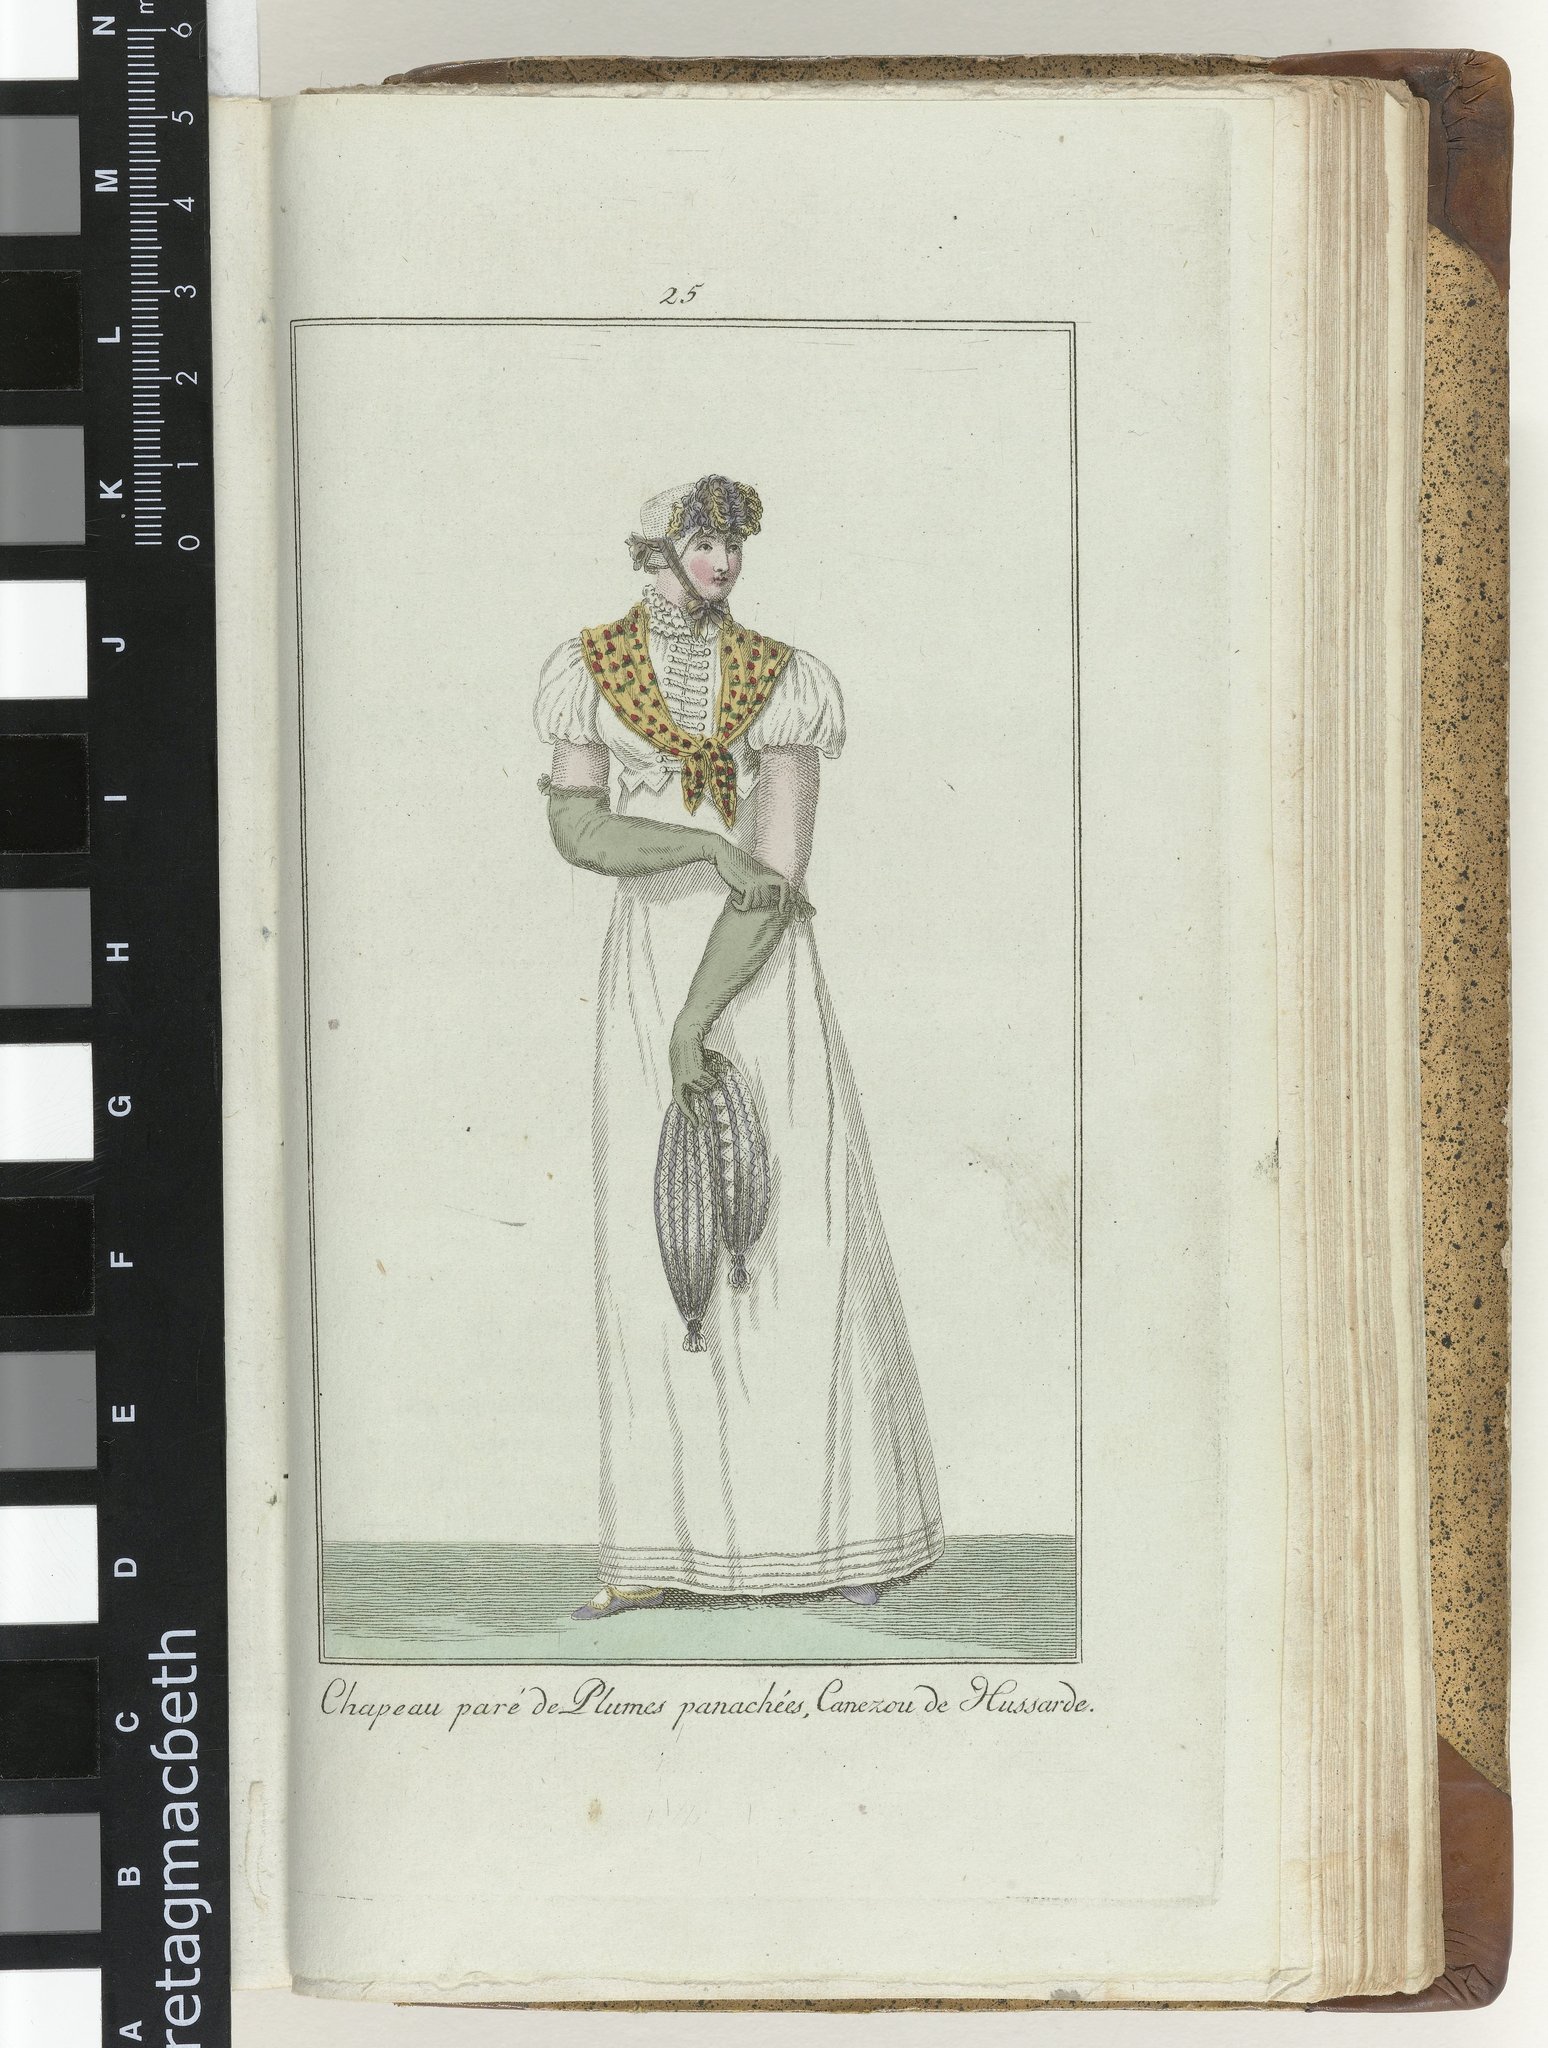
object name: magazine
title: Elegantia, of tijdschrift van mode, luxe en smaak voor dames, Oktober 1807, No. 25: Chapeau paré de Plumes panachées...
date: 1807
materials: paper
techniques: engraving, hand coloring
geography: amsterdam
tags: gloves, mittens (long gloves) (+ women's clothes), clothing for the upper part of the body (shawl) (+ women's clothes), clothing for the upper part of the body: blouse (+ women's clothes), head-gear (straw hat) (+ women's clothes), fashion plates, shoes, sandals (+ women's clothes), dress, gown (+ women's clothes), piece of clothing covering the breast or décolleté (fichu) (+ women's clothes)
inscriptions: caption: ‘Chapeau paré de Plumes panachées, Canezou de Hussarde’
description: Volgens de begeleidende tekst (p. 328): Japon van witte mousseline. 'Canezou à la Hussarde'. 'Fichu de laine' (wol); witte strohoed met 'plumes panachées'. Sjaal genaamd: 'Zéphyre'. Pistache kleurige handschoenen. Lilakleurige satijnen schoenen. Prent uit het modetijdschrift Elegantia, of tijdschrift van mode, luxe en smaak voor dames 1807-1814 (onderbroken door de periode 1811-1813).